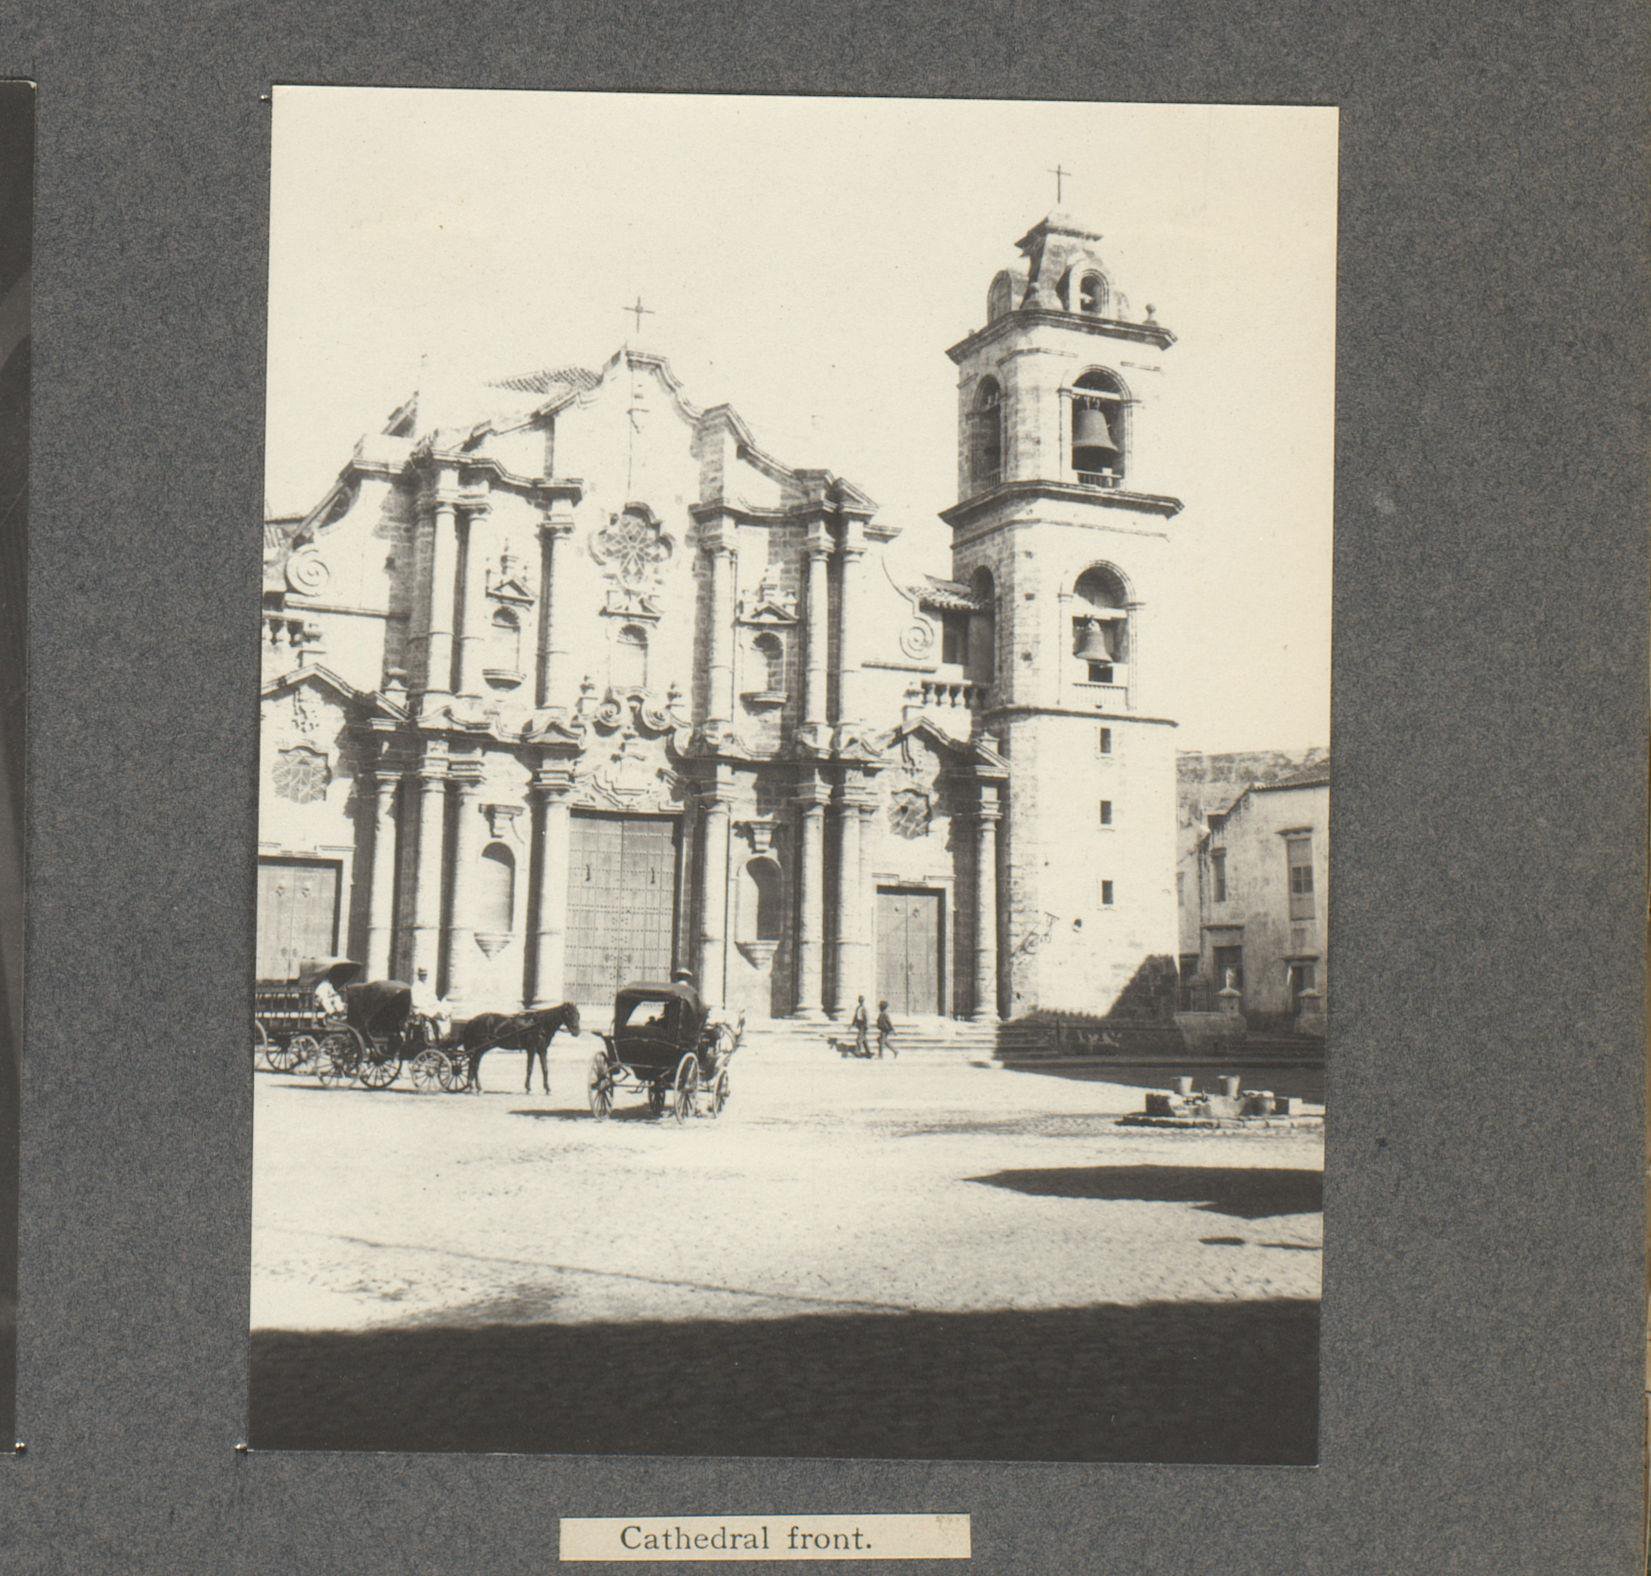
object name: photograph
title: Cathedral front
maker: Anonymous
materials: paper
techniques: platinum process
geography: havana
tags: tower, clock tower ~ monumental adornment, parts of church exterior and annexes: façade